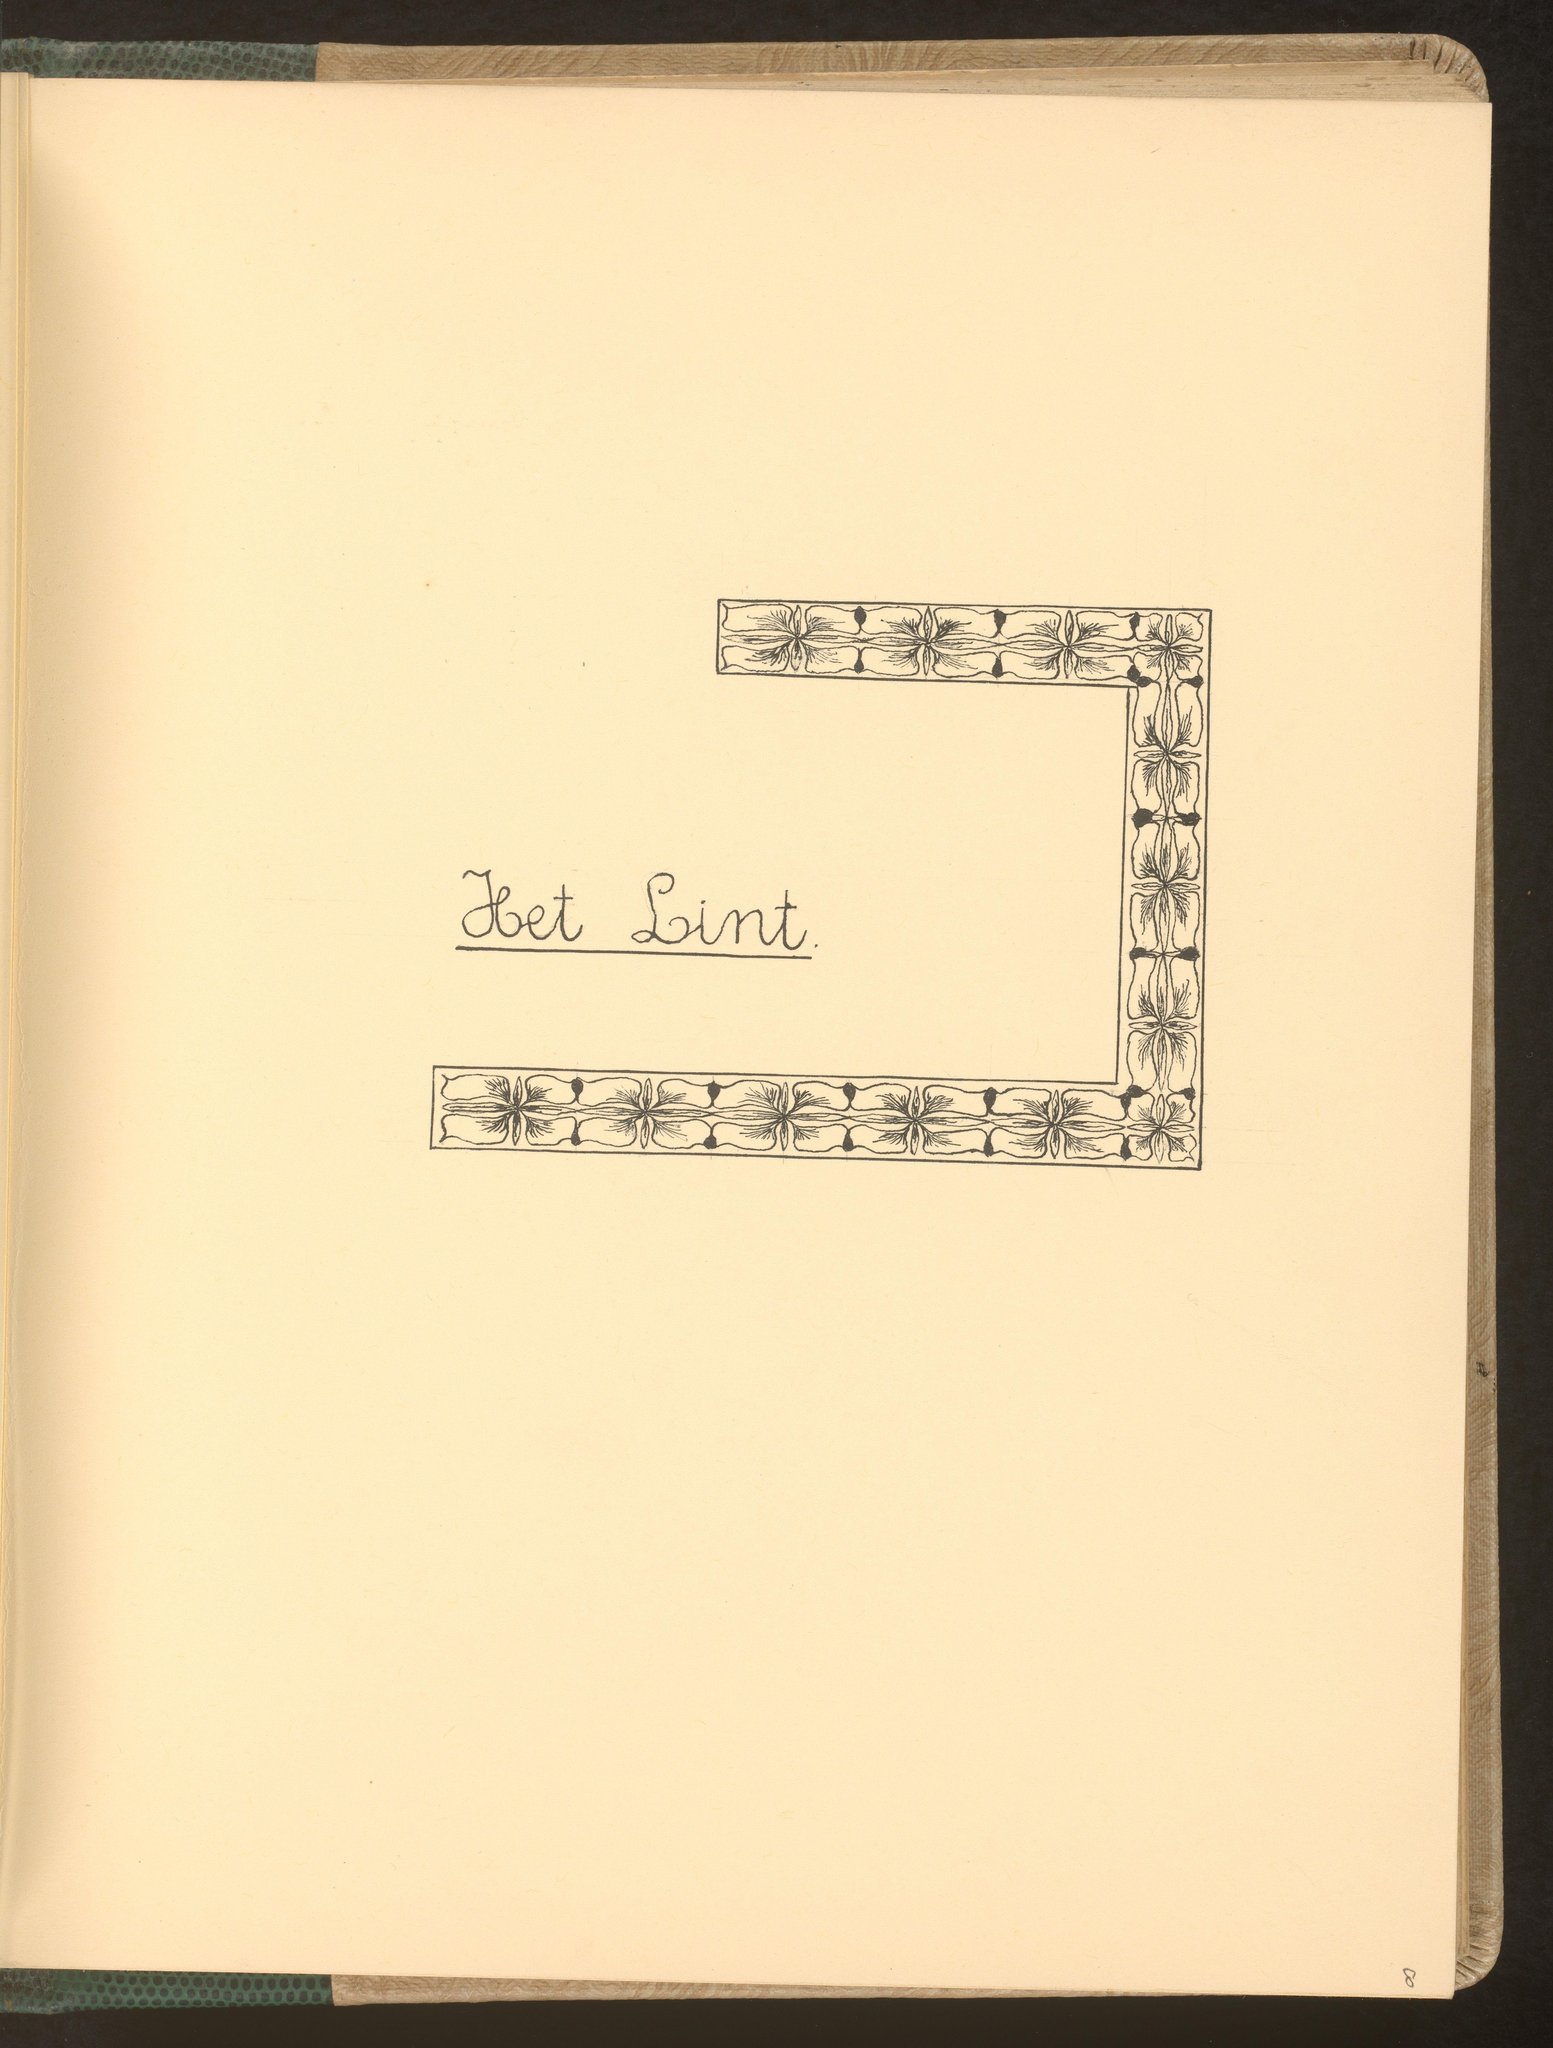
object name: album leaf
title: Het Lint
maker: Anonymous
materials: ink, paper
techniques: handwriting, pen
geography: lochem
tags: amsterdam, the hague, willem drees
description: Handgeschreven titel voor de foto op het volgende blad. Onderdeel van het fotoalbum over de opening van het bejaardenhuis De Berkelhof in Lochem door premier Willem Drees op 8 augustus 1953.